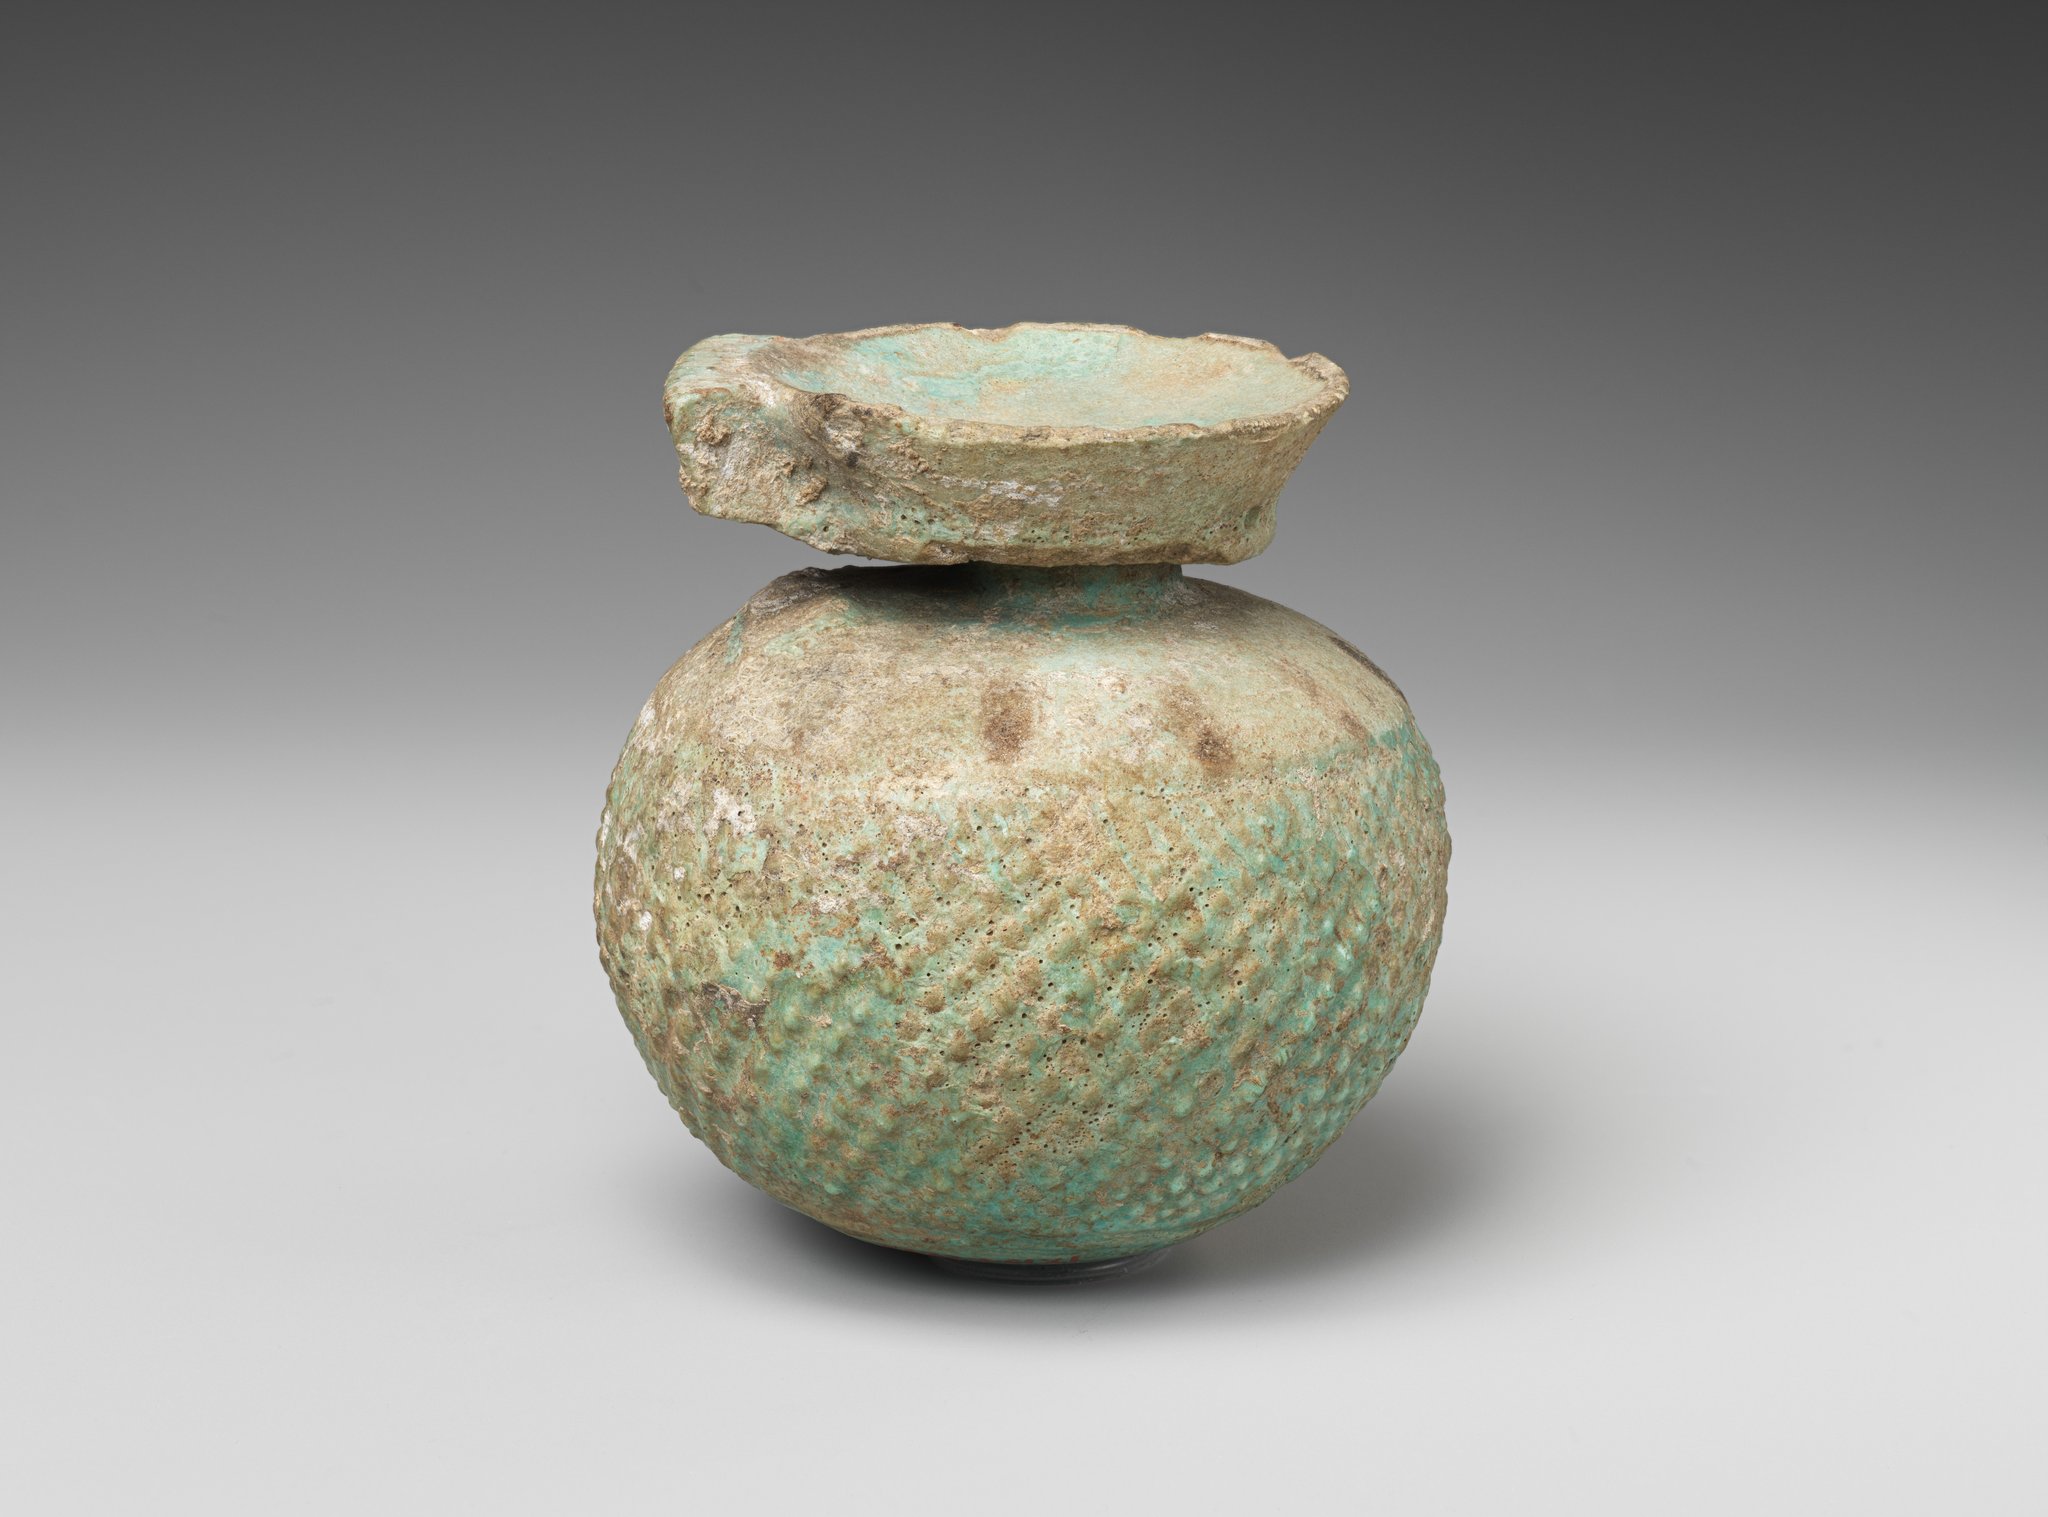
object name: jug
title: Aryballos (perfume jar)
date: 600-501 BCE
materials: faience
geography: egypt